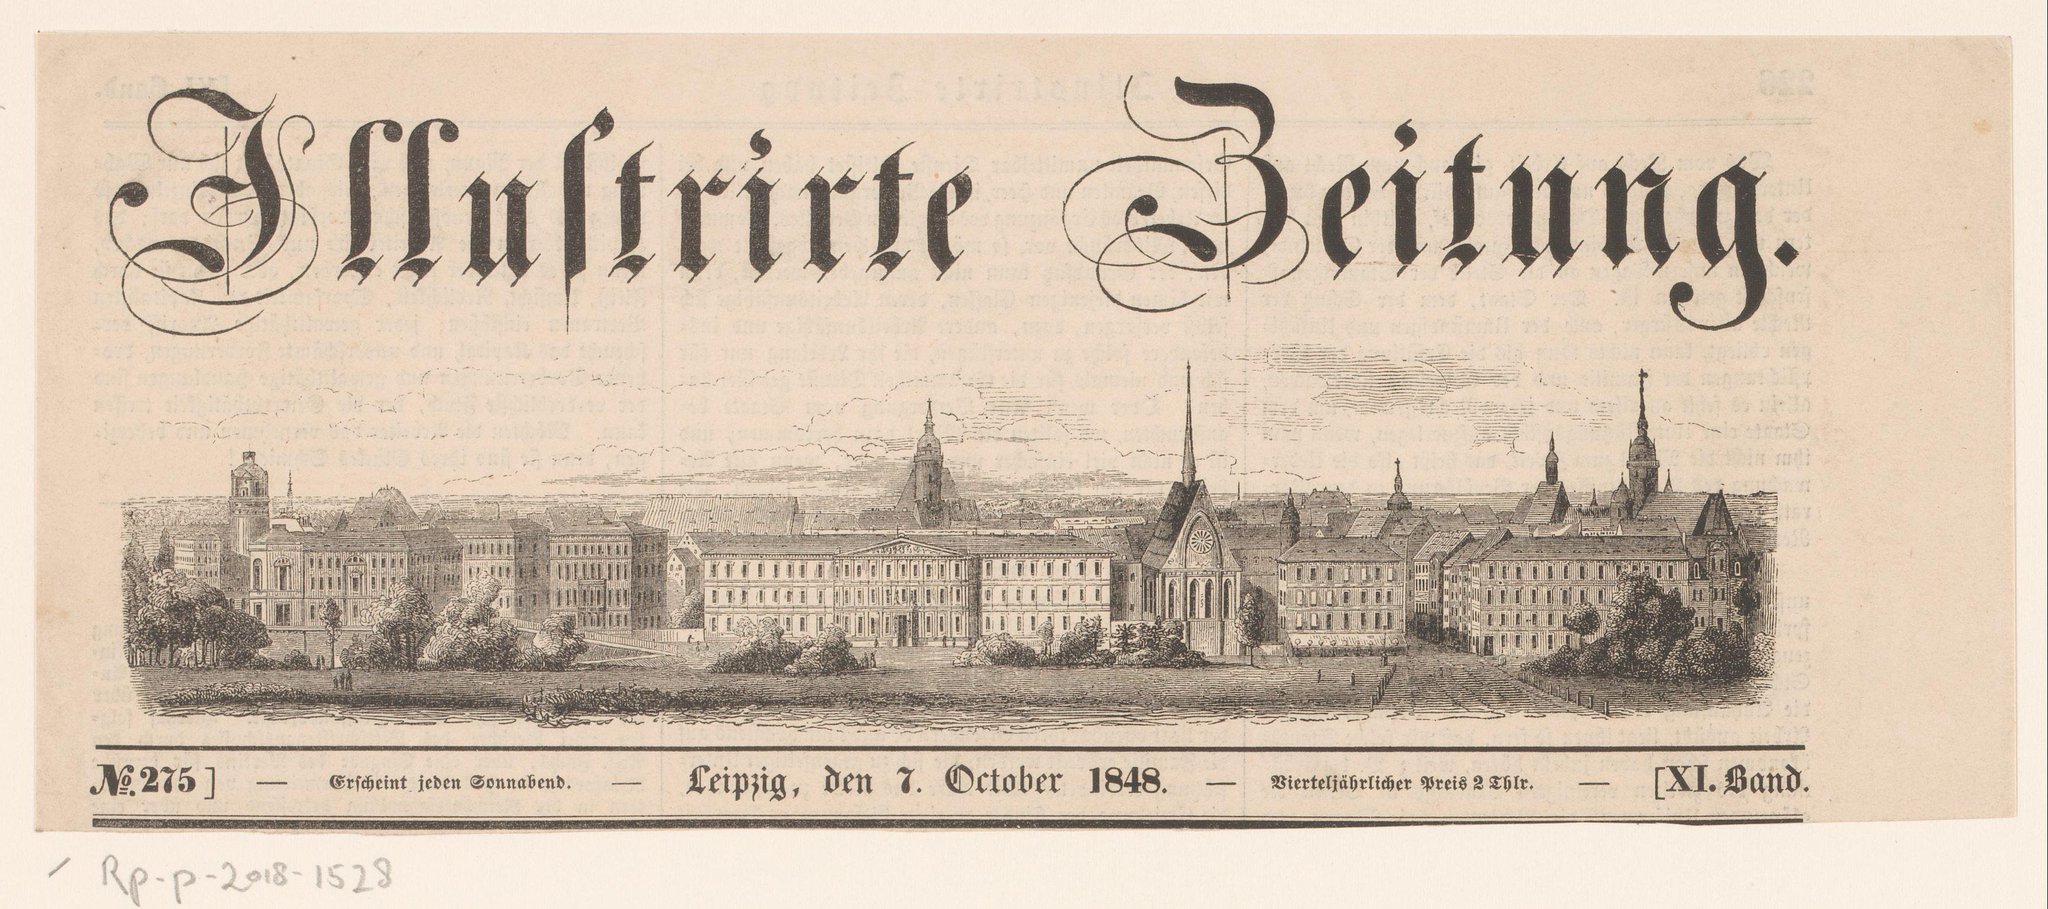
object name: print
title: Kop van de 'Illustrirte Zeitung', met gezicht op Leipzig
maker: Anonymous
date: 1848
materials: paper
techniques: etching, letterpress printing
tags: prospect of city, town panorama, silhouette of city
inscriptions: date